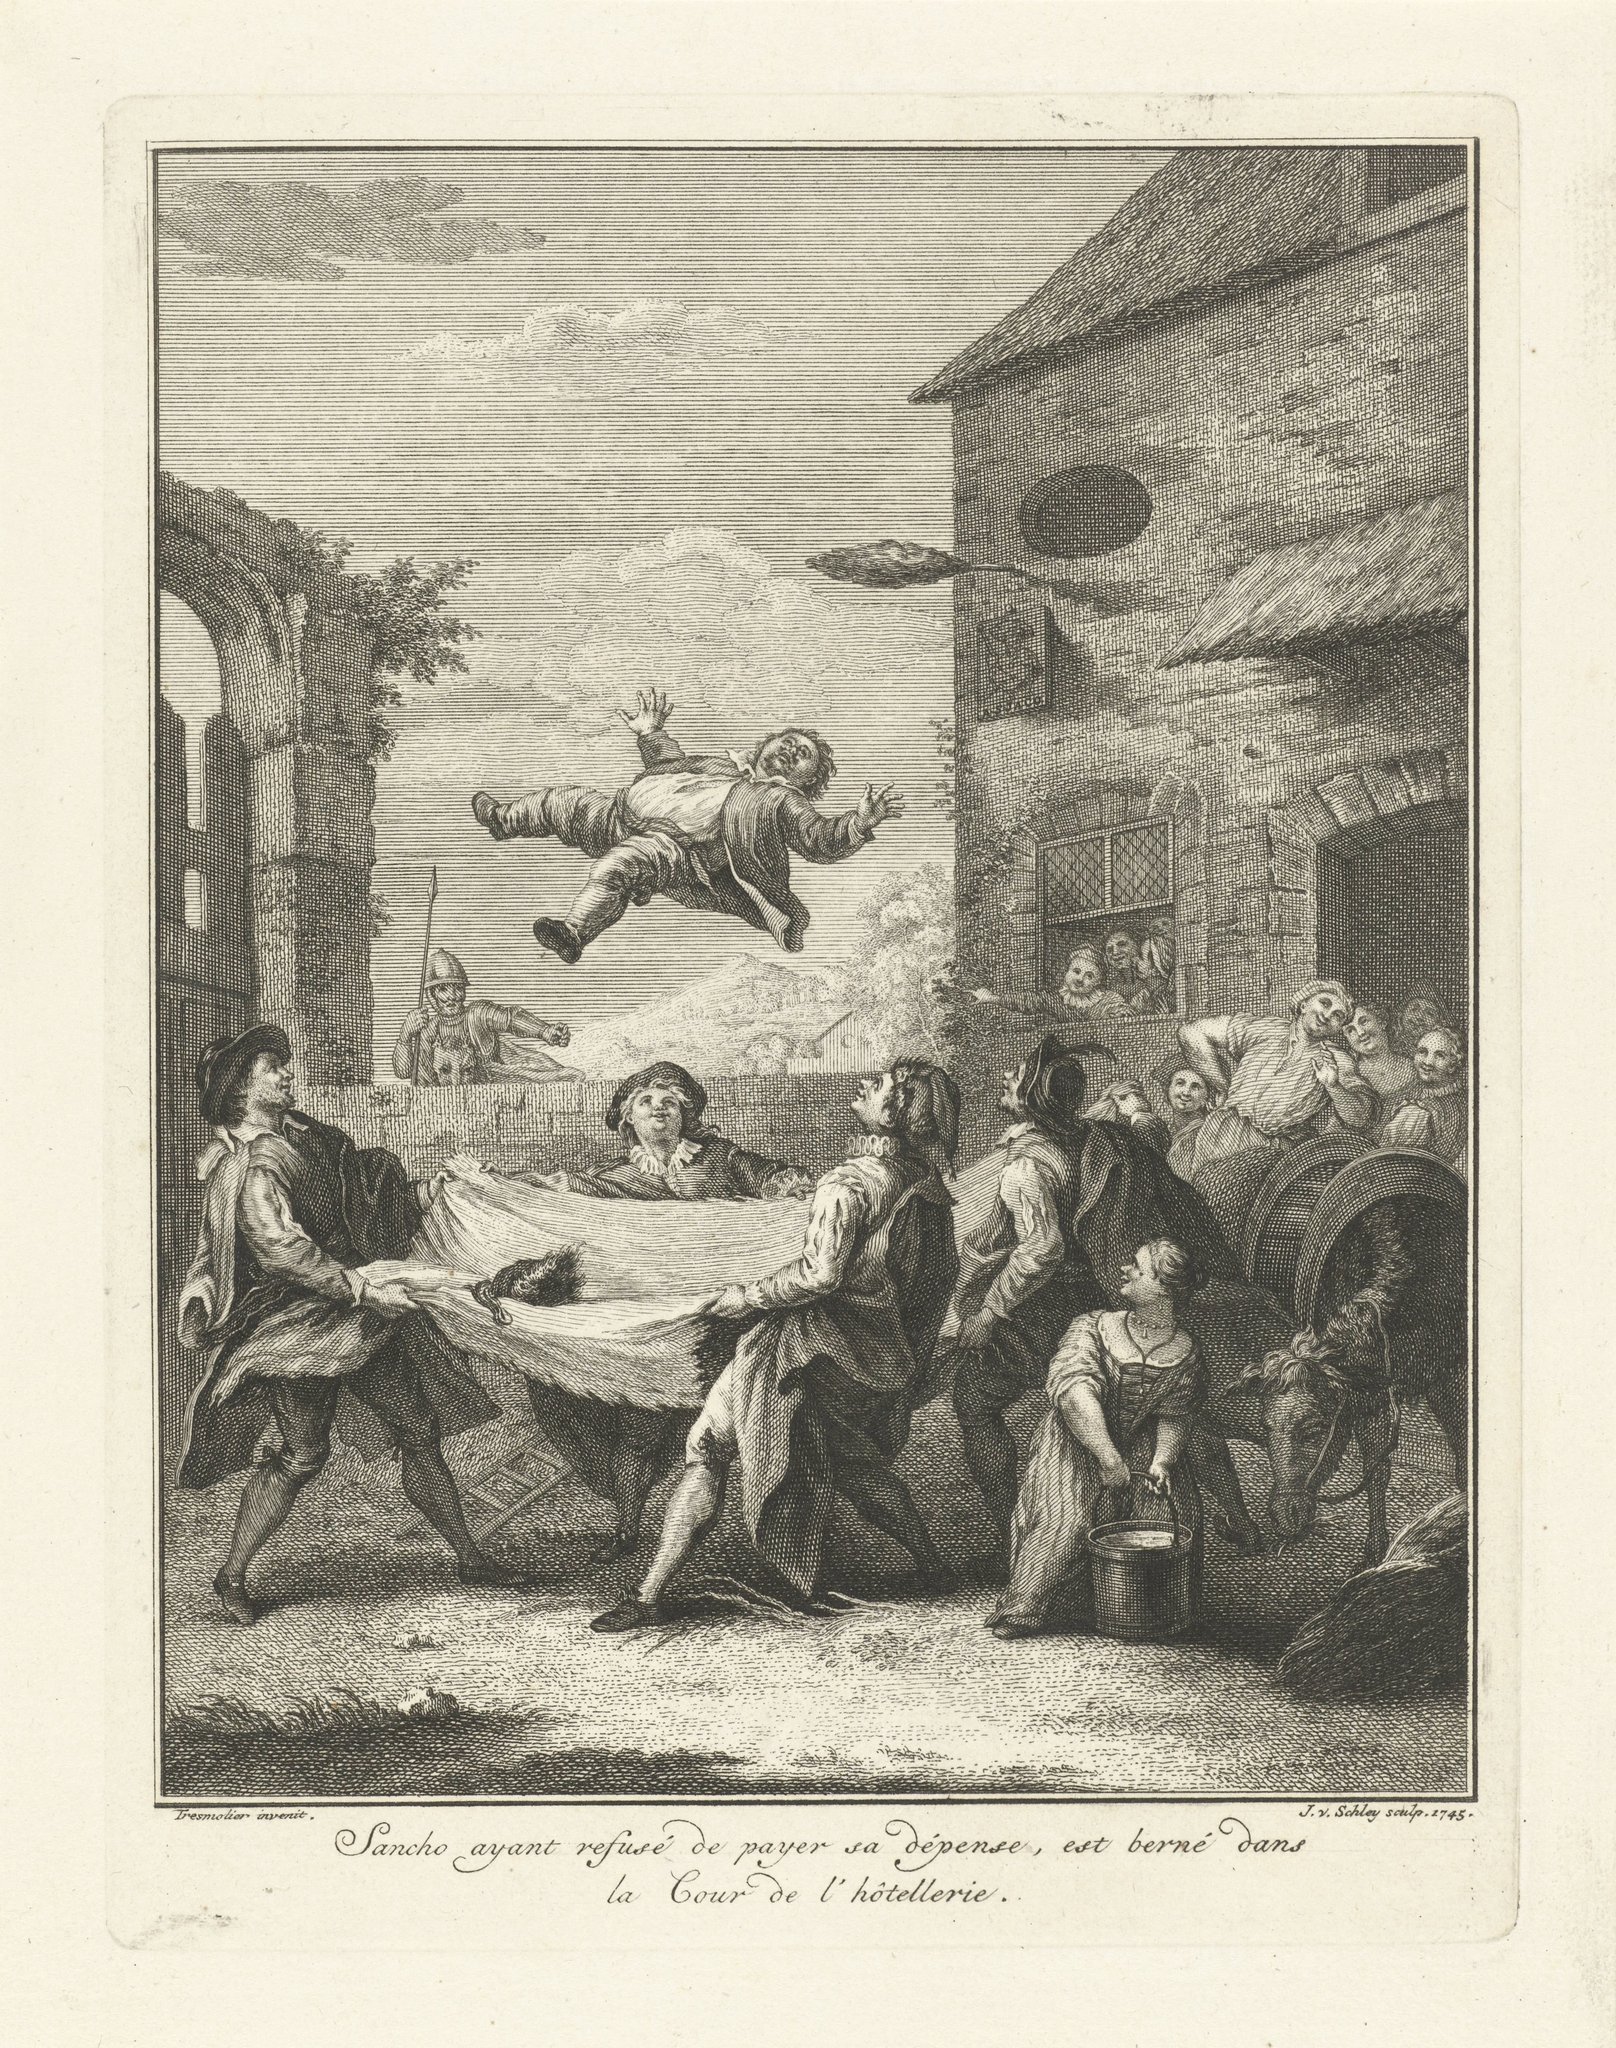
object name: print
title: Sancho wordt omhoog gegooid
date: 1745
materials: paper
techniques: engraving, etching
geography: amsterdam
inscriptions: date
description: Voor een herberg wordt Sancho, de knecht van Don Quichot, door een groep mannen met een deken op gegooid, omdat ze niet betaald hebben voor de overnachting. Bij de ingang staat de waard te lachen en achter de schutting staat Don Quichot.